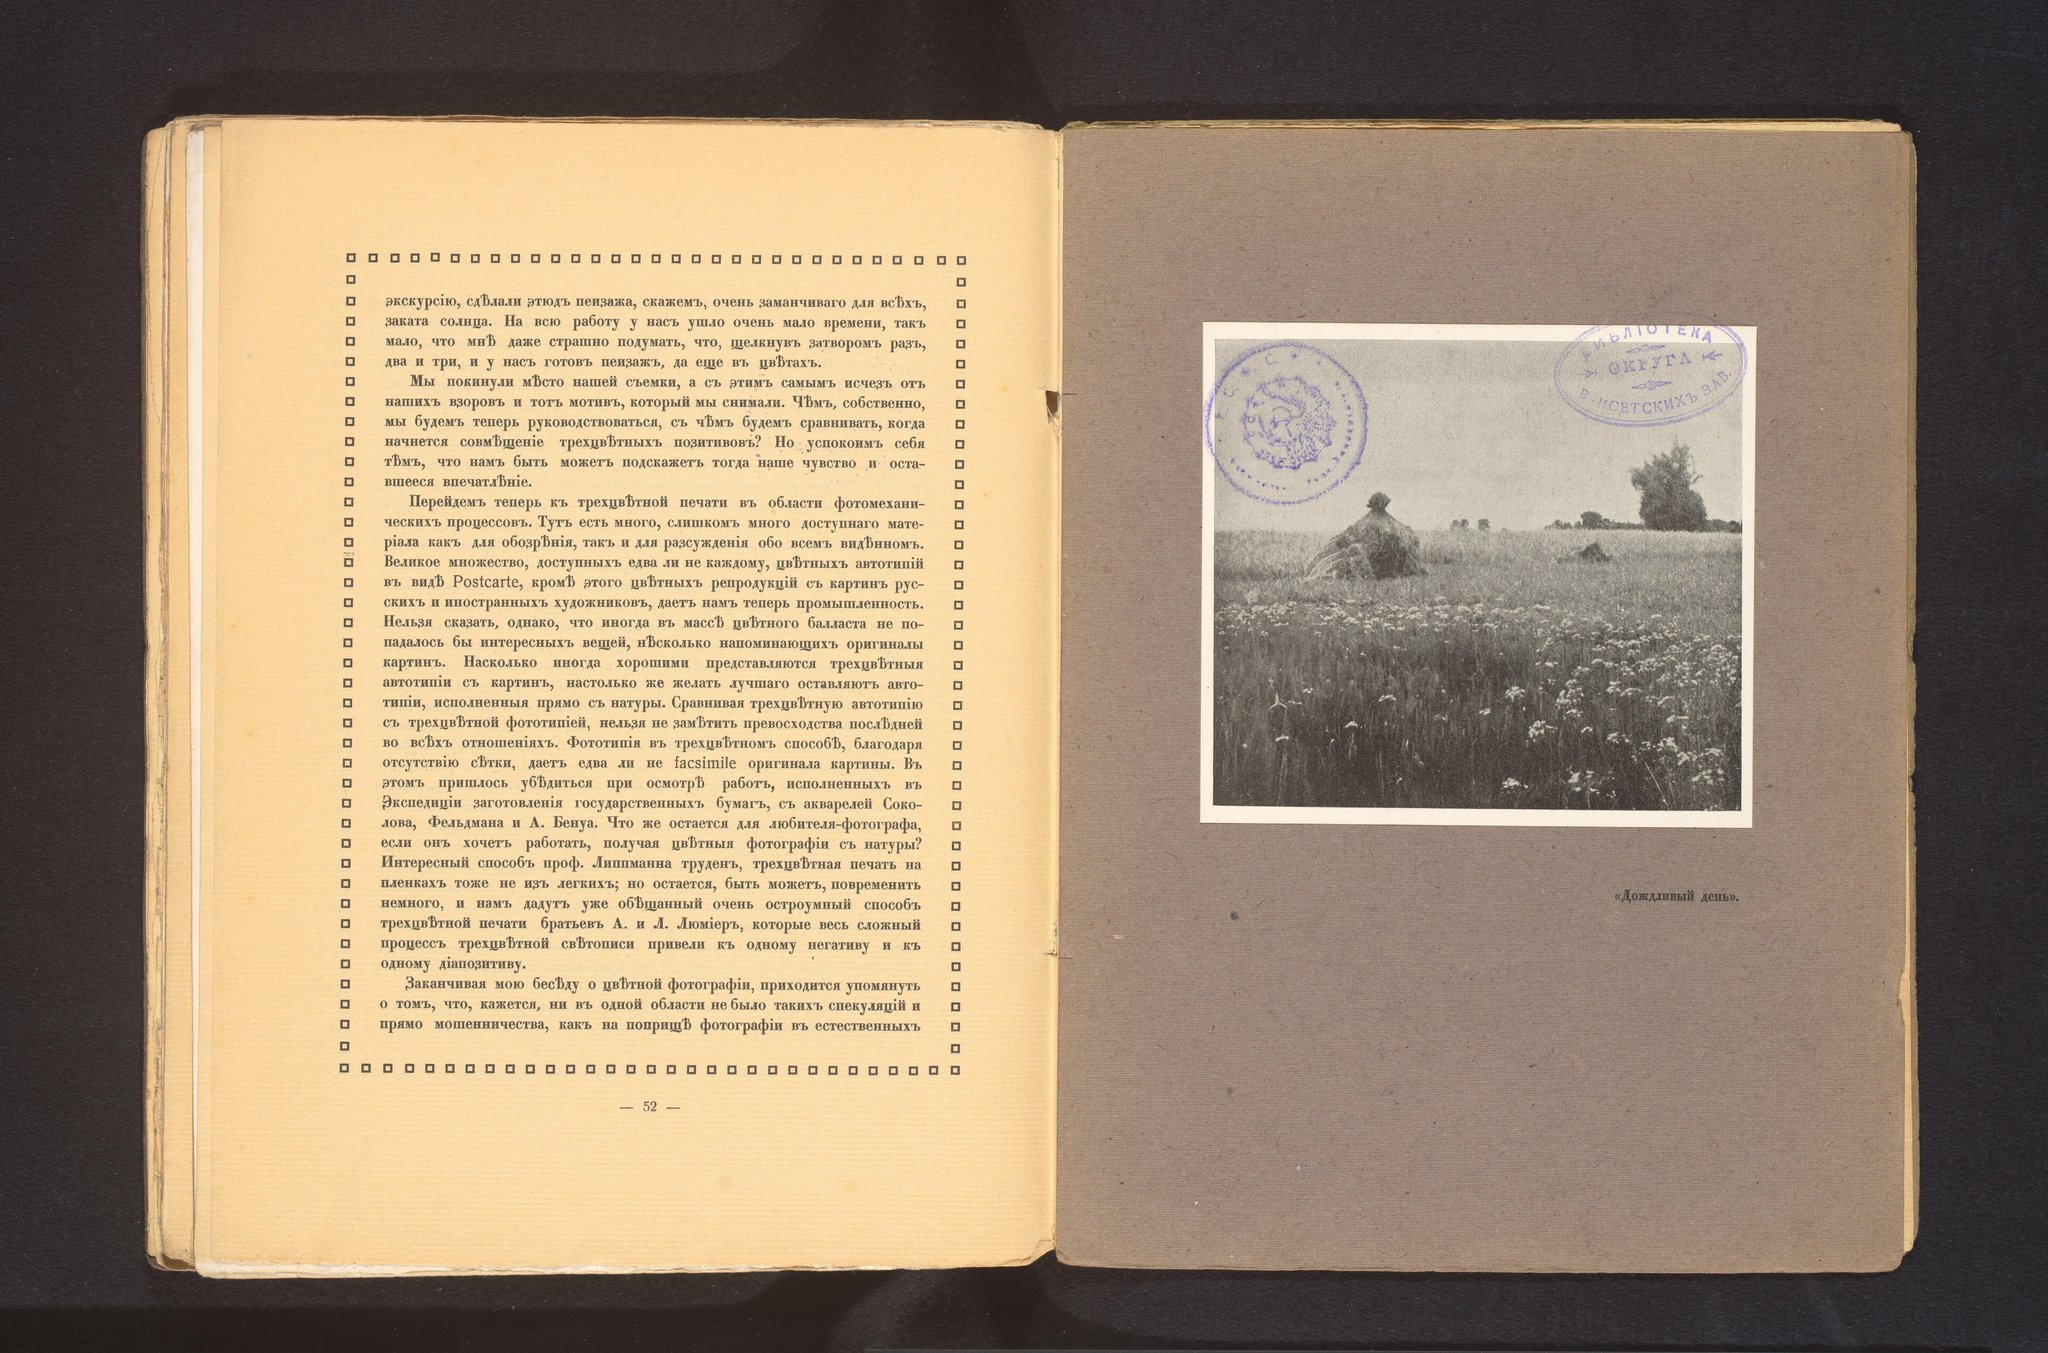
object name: photomechanical print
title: Дождднвьій день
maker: Anonymous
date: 1897-1907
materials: paper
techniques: autotype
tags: meadow, pasture, hay-stack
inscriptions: inscription